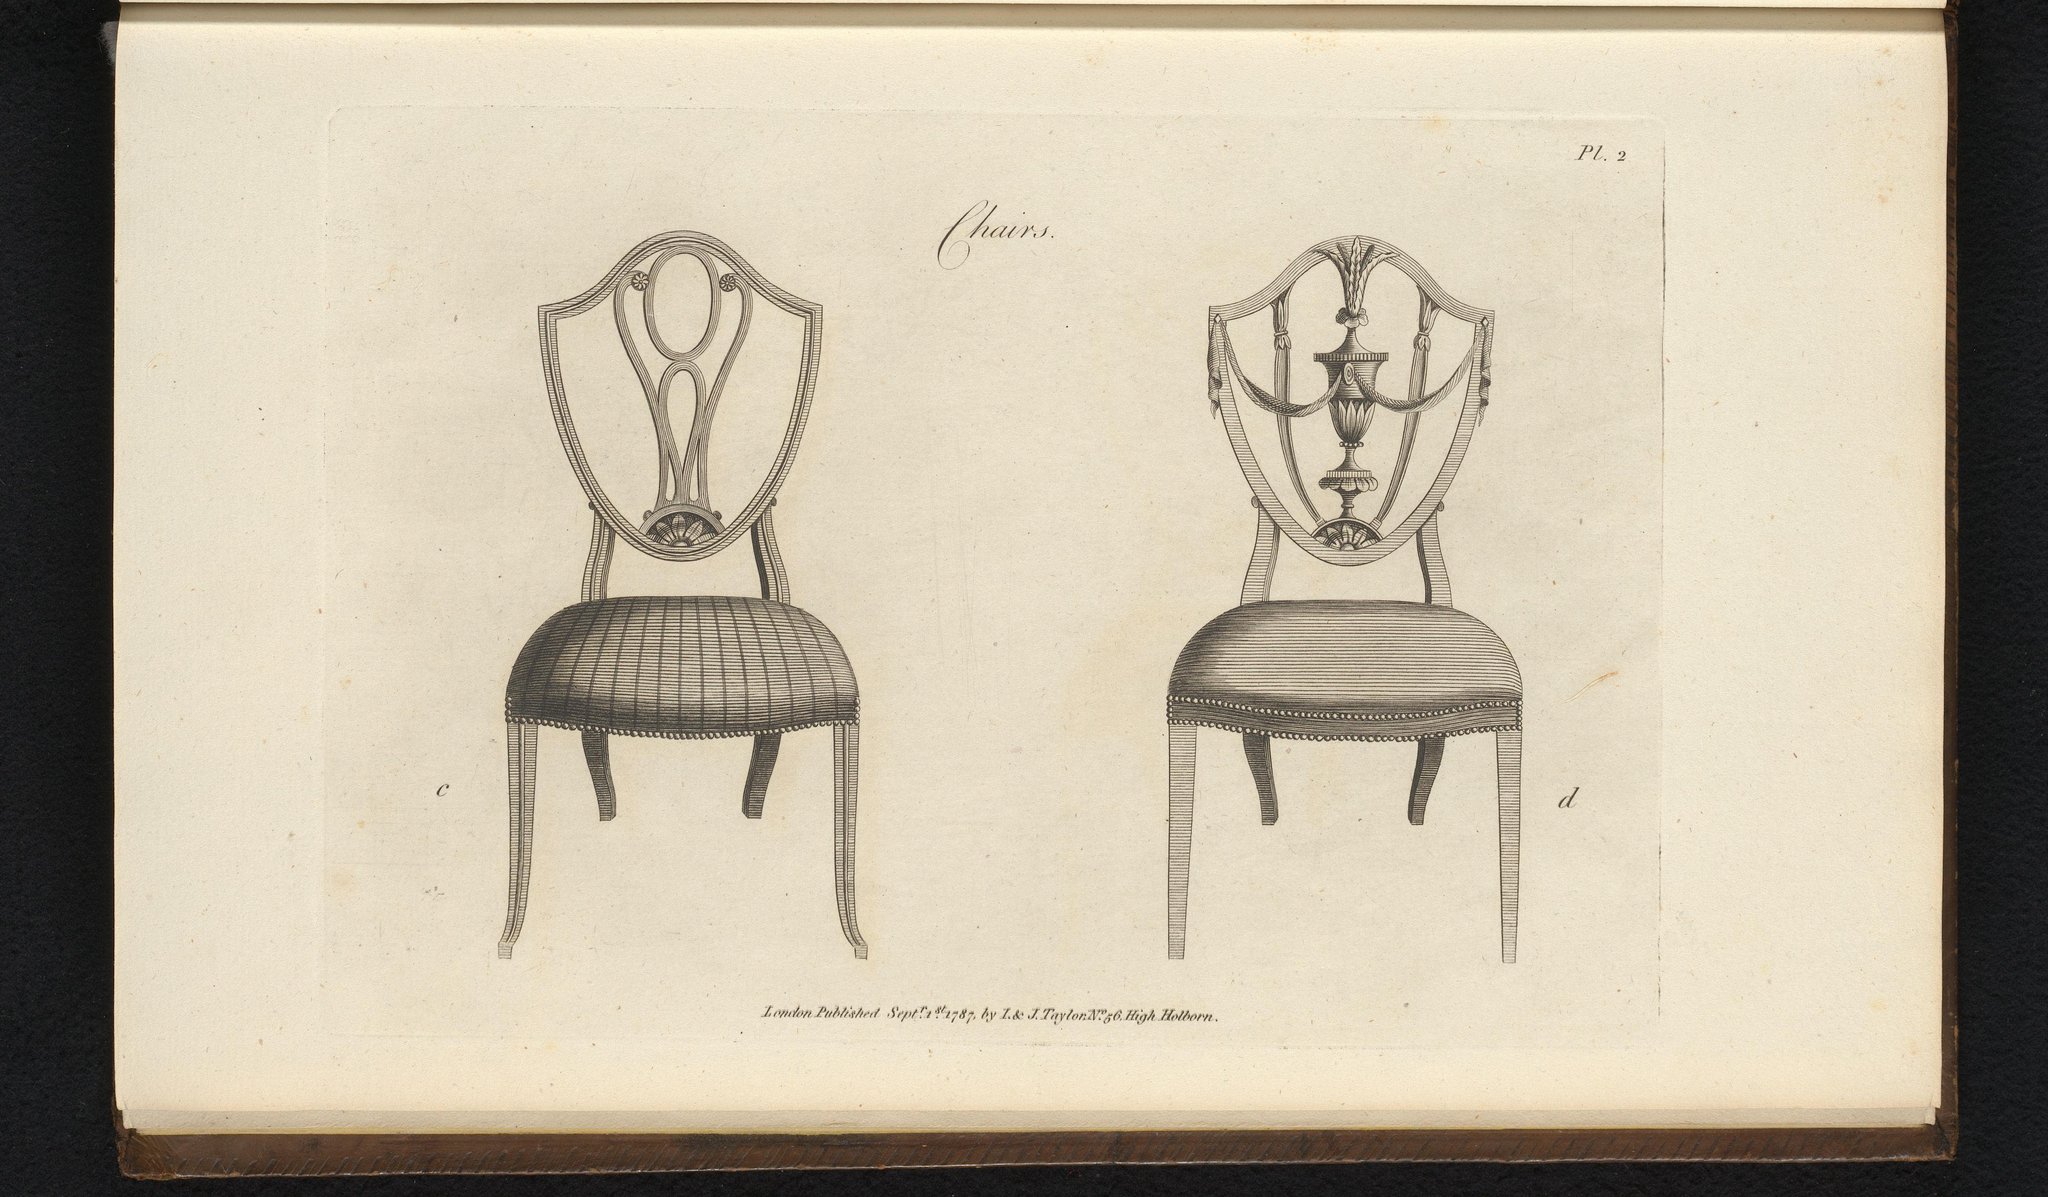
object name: print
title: Meubels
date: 1787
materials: paper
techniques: engraving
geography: holborn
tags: chair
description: Genummerd: Pl. 2. Stoelen gemerkt: c en d. Prent maakt deel uit van een boek.